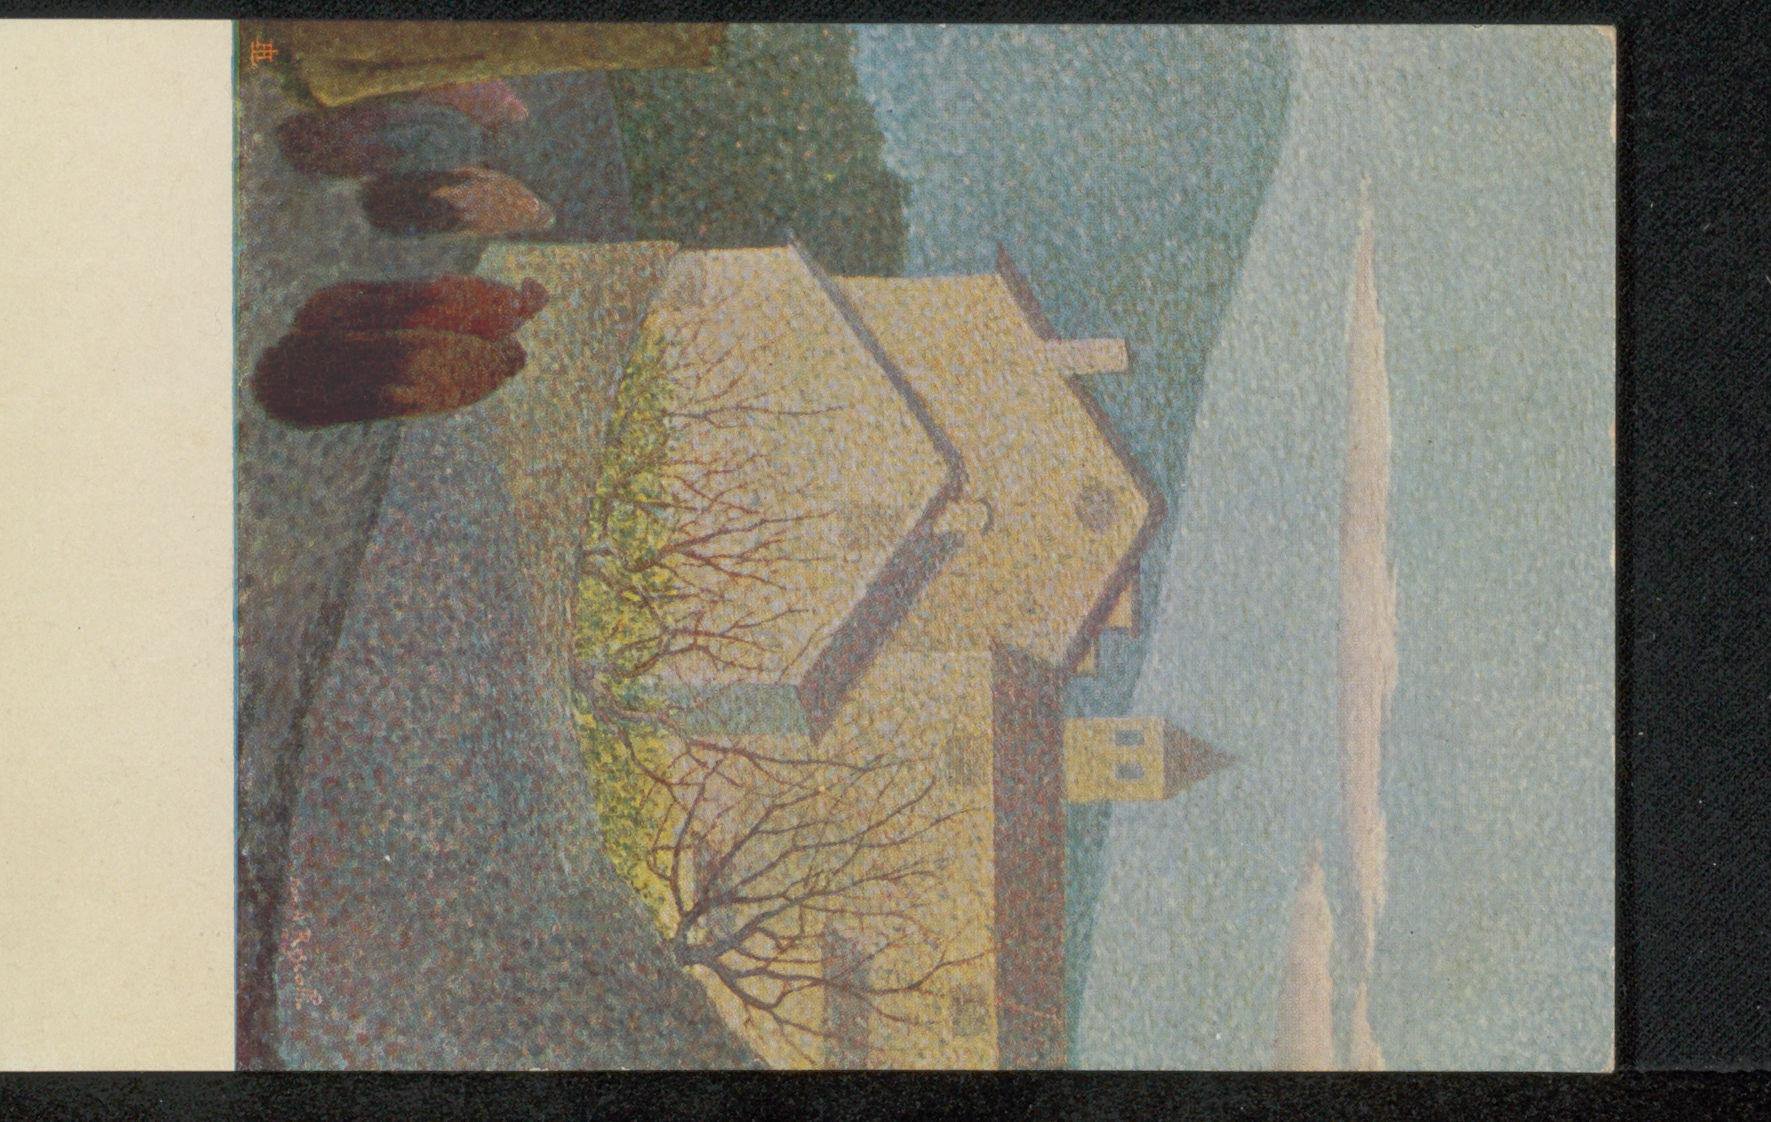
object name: ansichtkaart, prentbriefkaart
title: Prentbriefkaart aan Philip Zilcken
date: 1894-1930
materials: cardboard, ink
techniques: pen, writing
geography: milan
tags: the hague, painter, draughtsman, philip zilcken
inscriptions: collector's mark: ‘RPK’